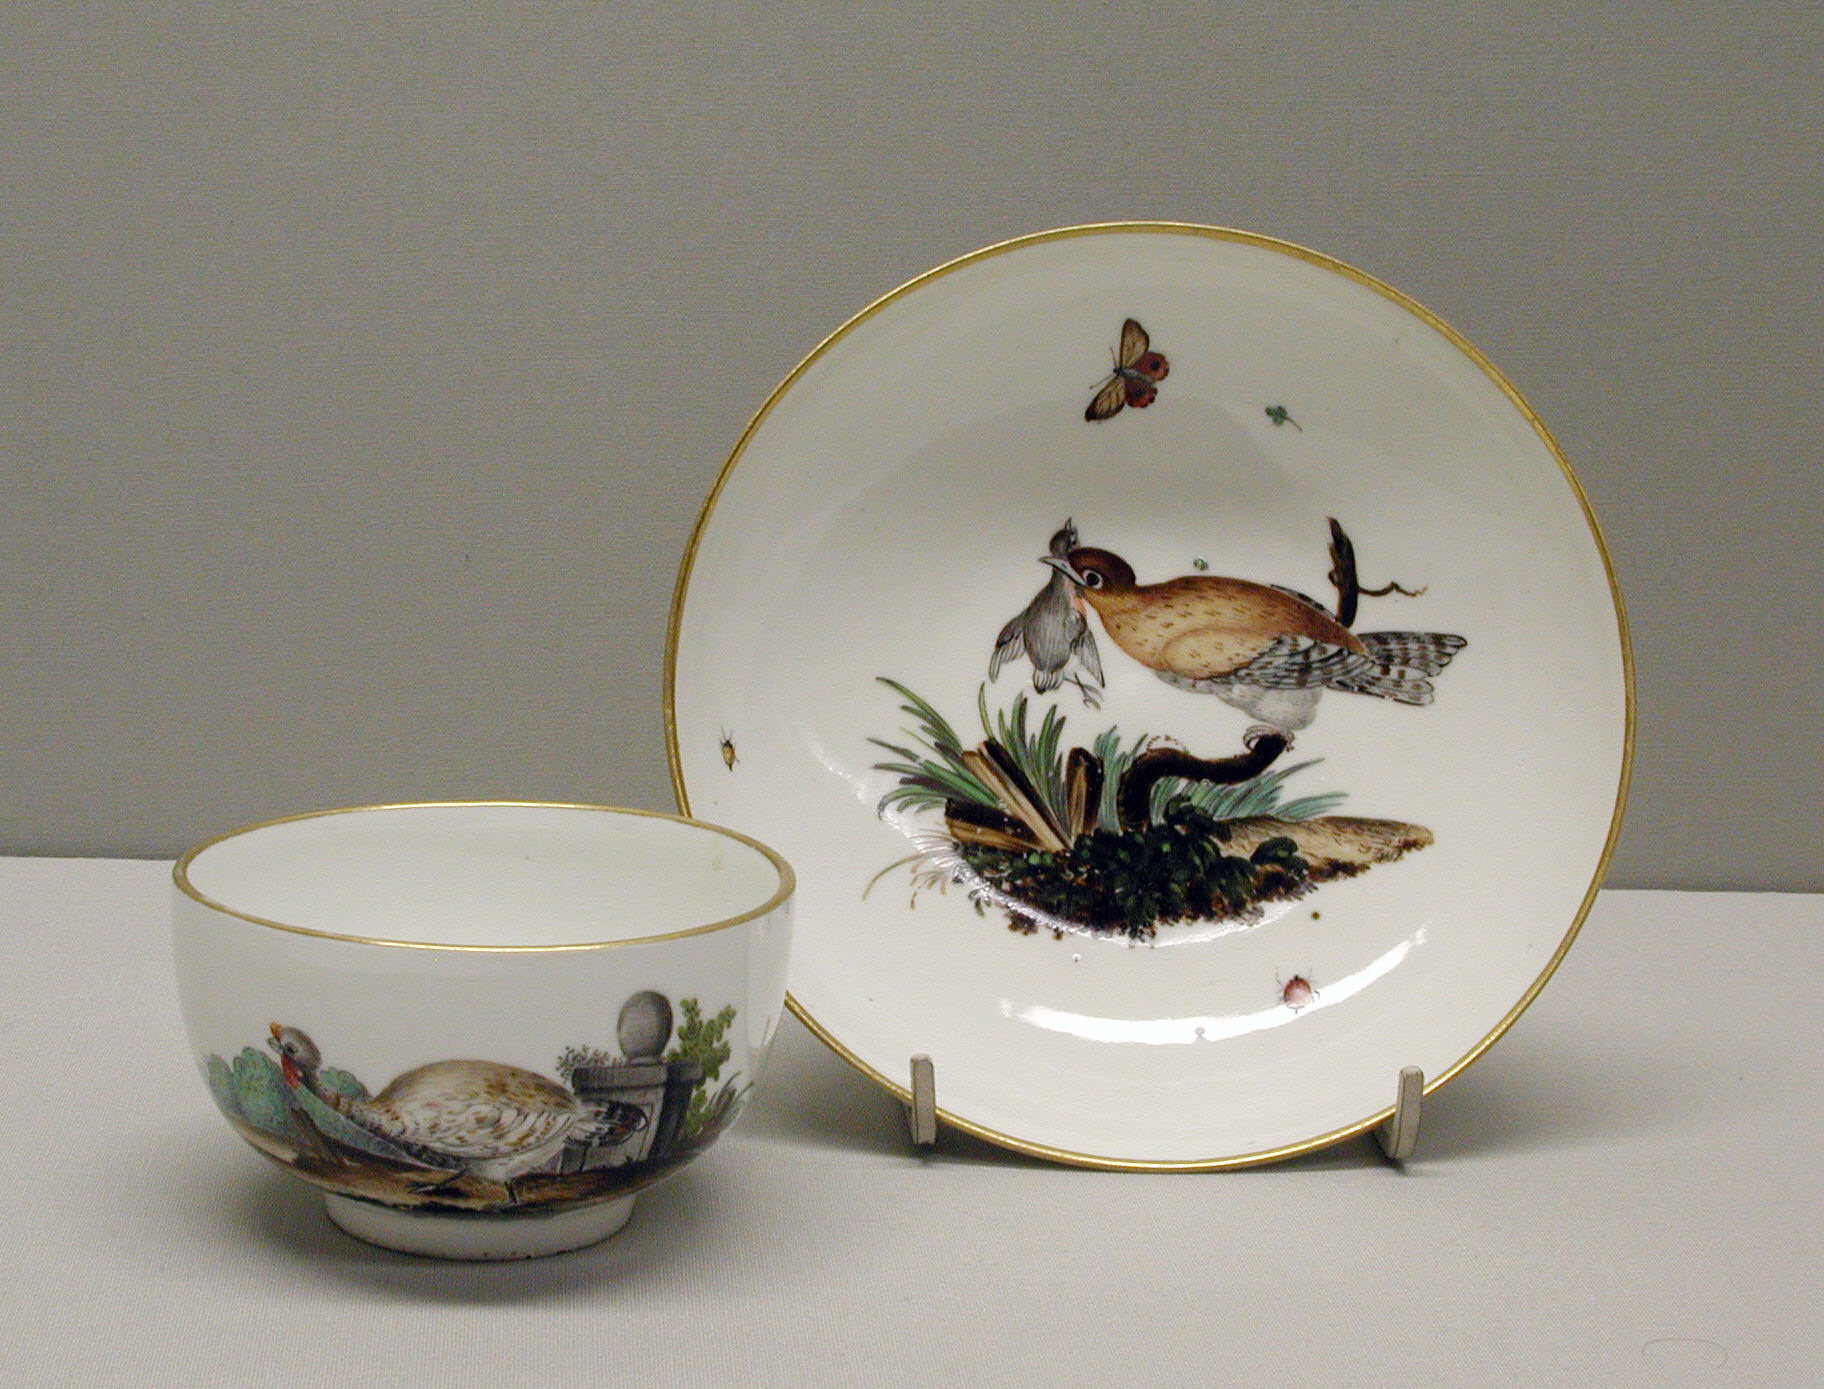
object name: teacup and saucer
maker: höchst manufactory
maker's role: manufactory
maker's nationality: german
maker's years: 1746-1796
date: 1775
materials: hard paste porcelain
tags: birds,butterflies